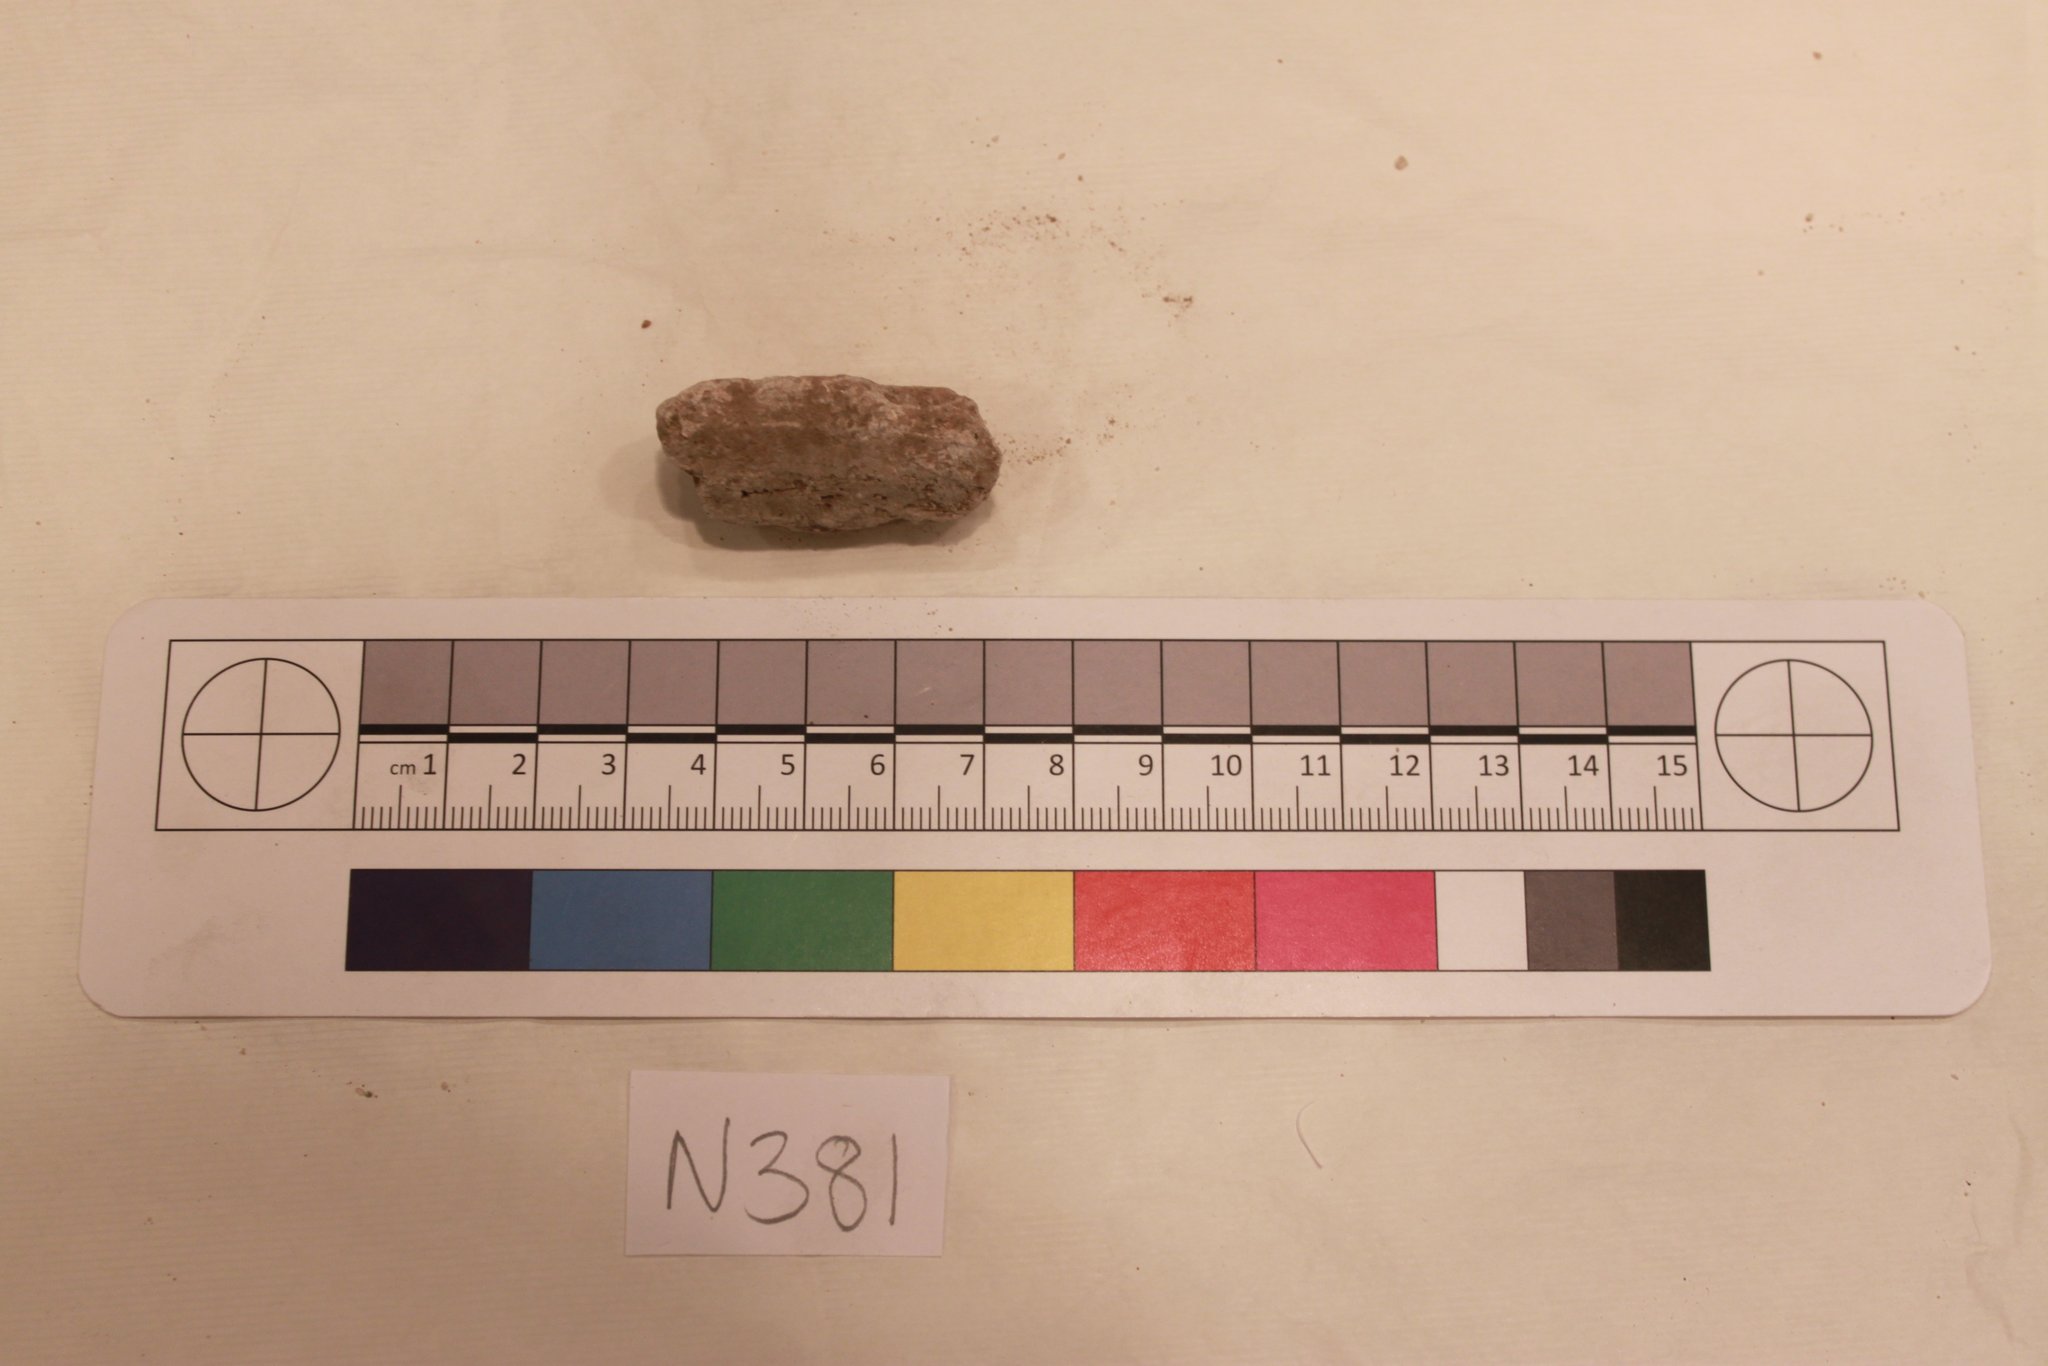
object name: fragment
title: Stucco Fragment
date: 701-1200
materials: plaster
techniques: carving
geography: iran